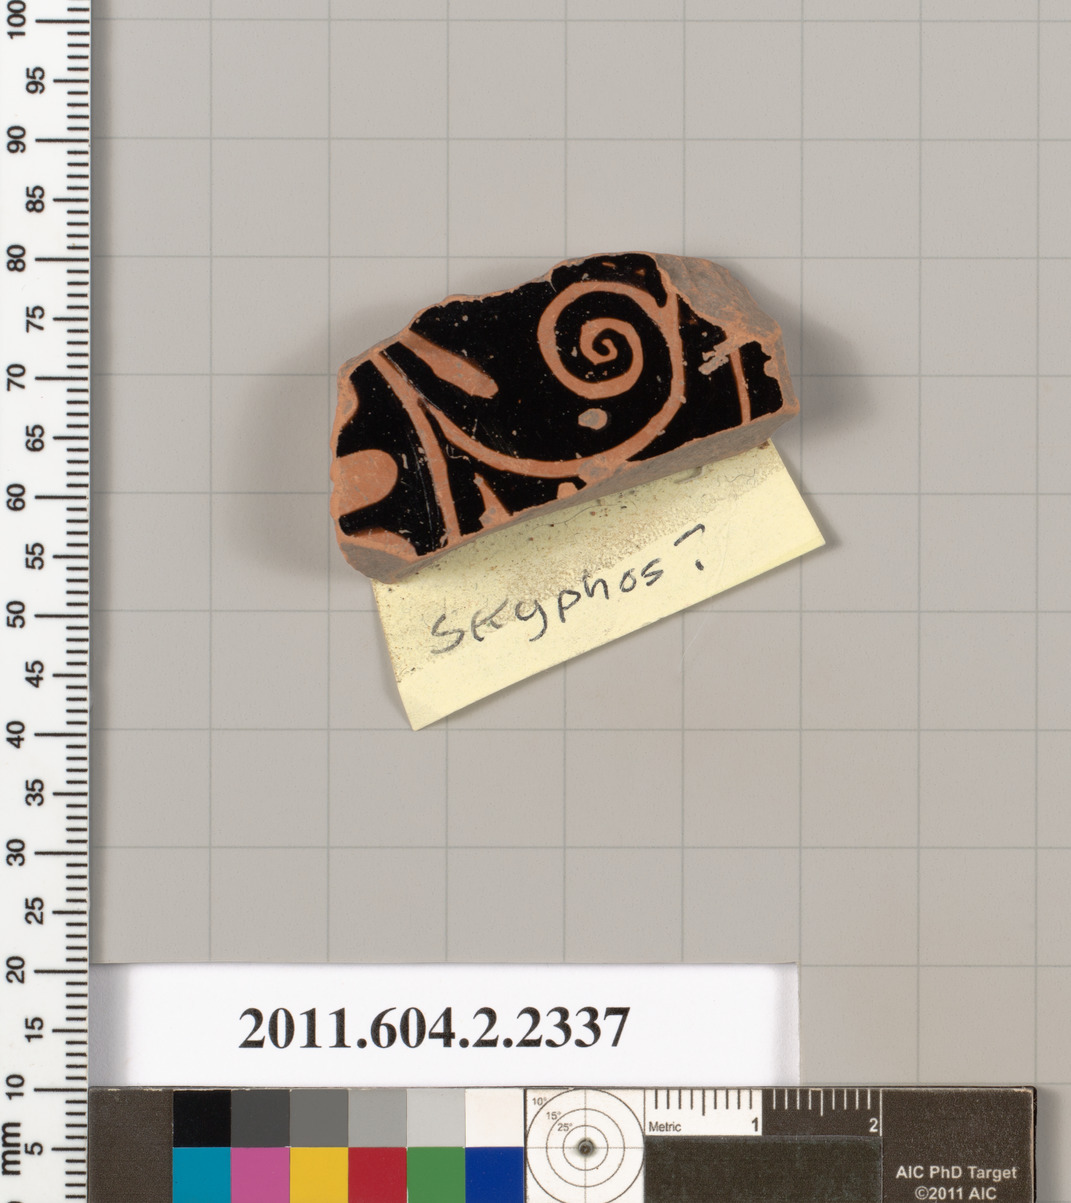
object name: skyphos fragment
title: Terracotta fragment of a skyphos (deep drinking cup)?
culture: greek, attic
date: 500-476 BCE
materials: terracotta